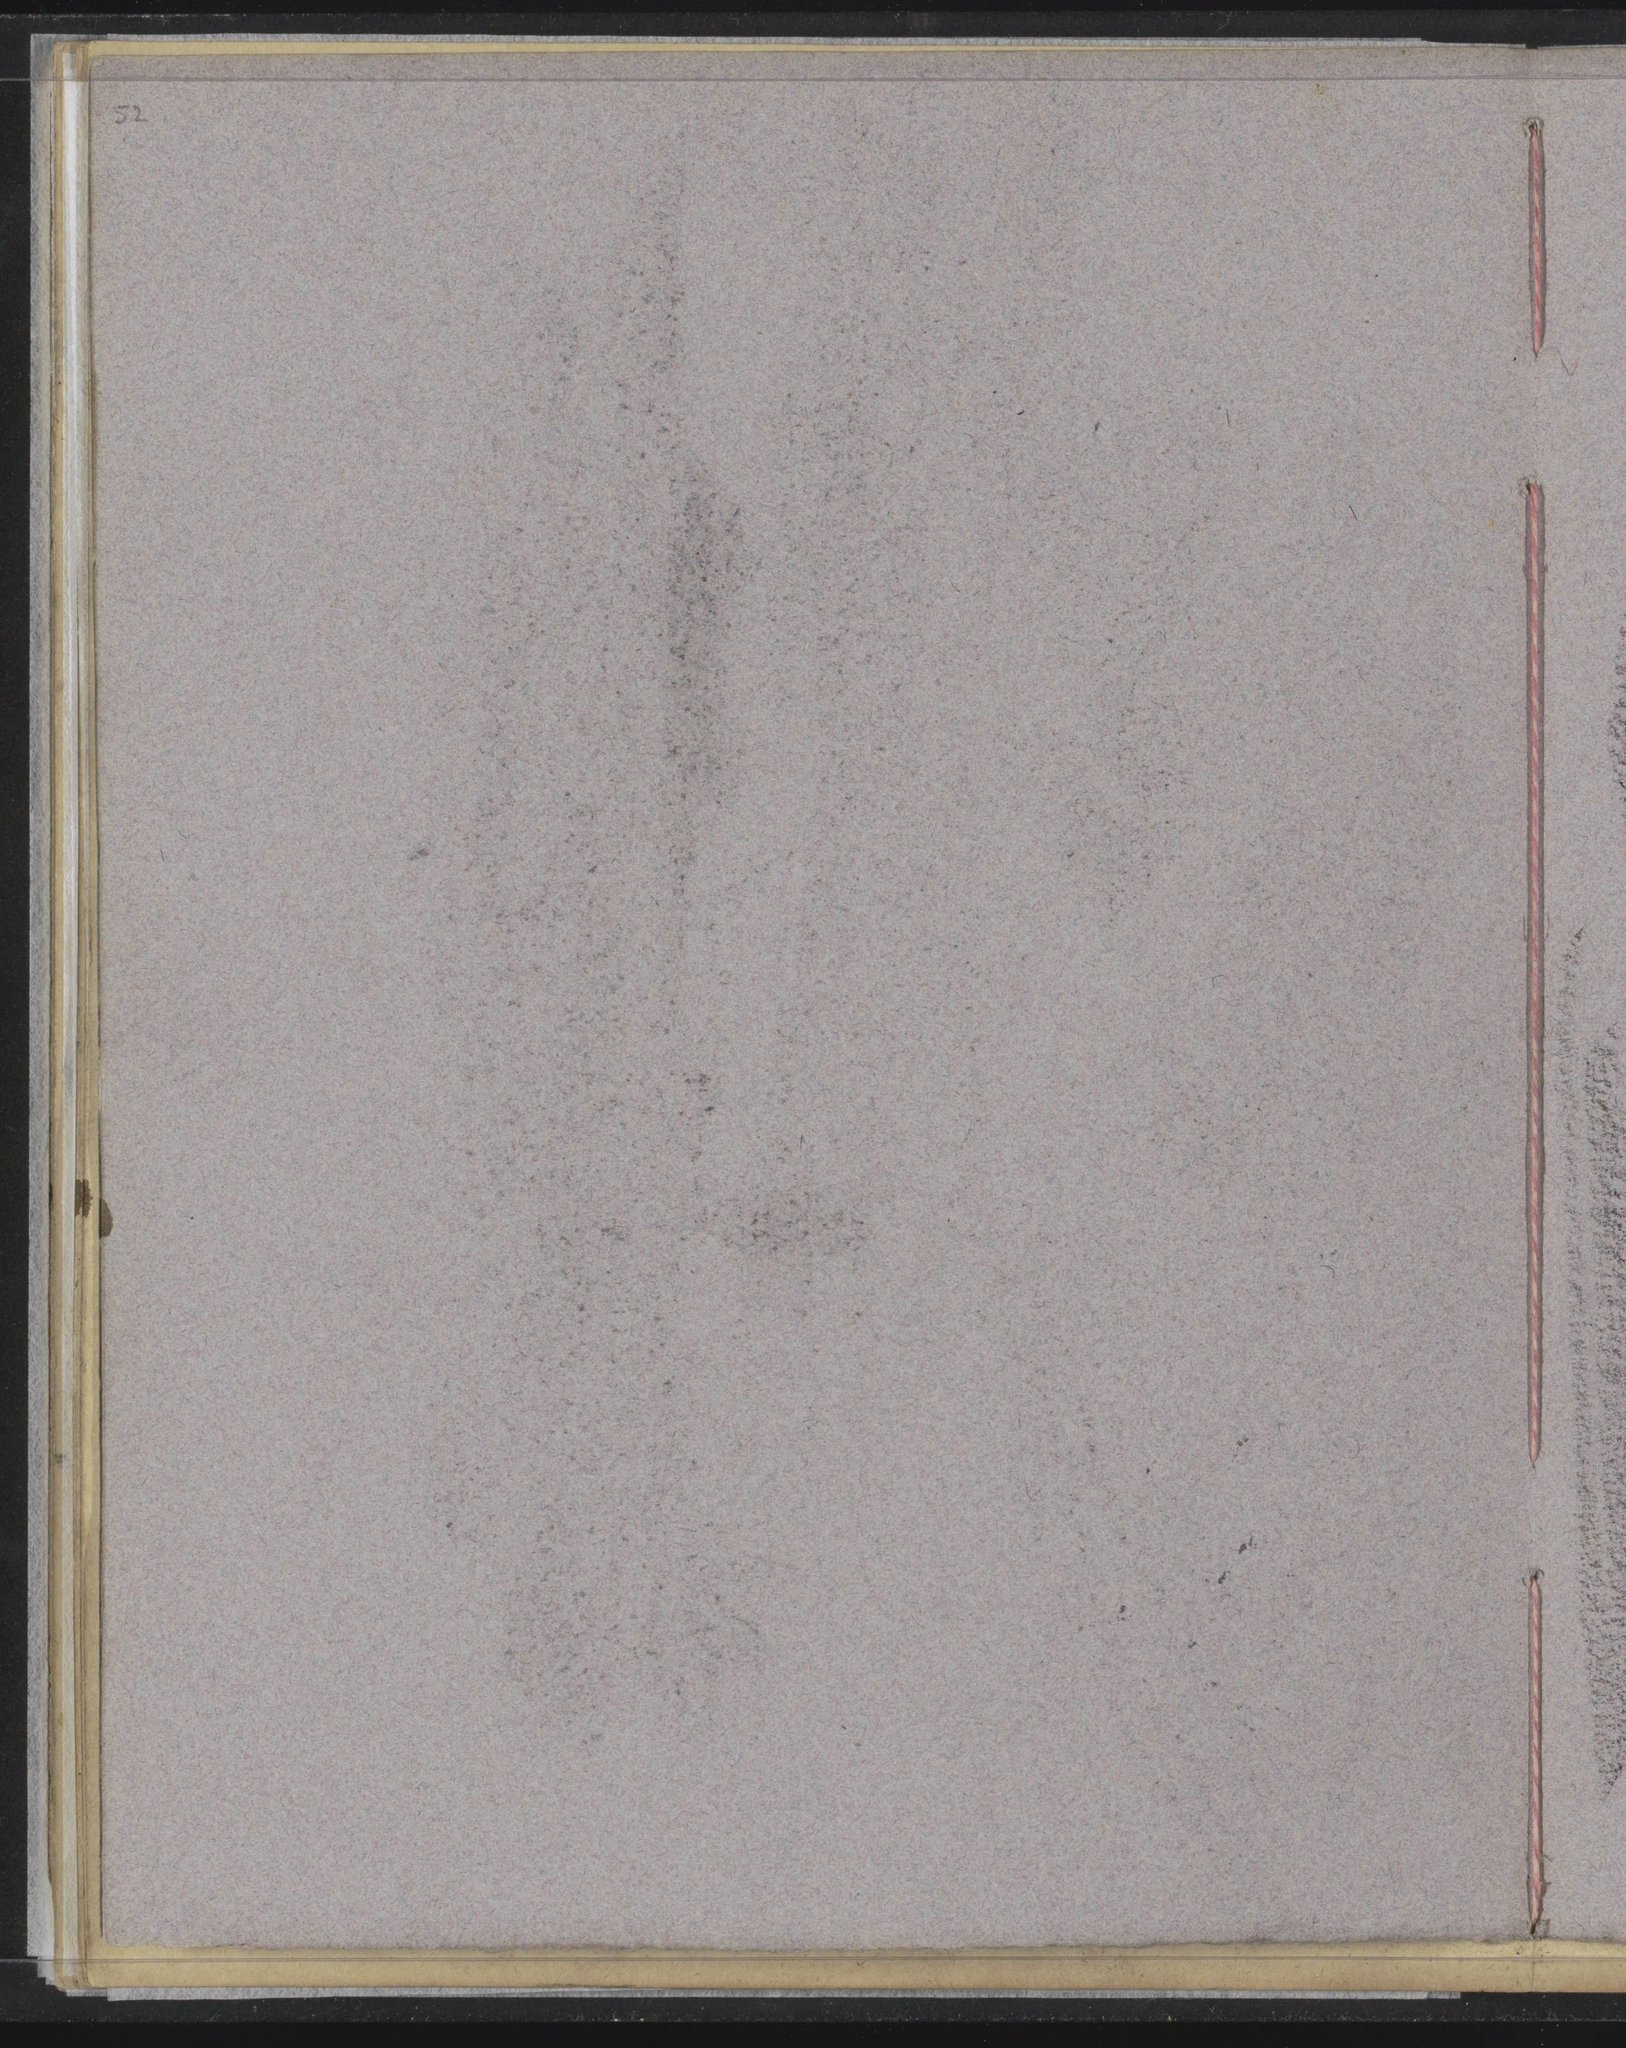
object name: sketchbook leaf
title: Abklatsch van de krijttekening op pagina 53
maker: willem witsen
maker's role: draughtsman, painter, print maker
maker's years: 1860-1923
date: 1887-1888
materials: paper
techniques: printmaking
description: Pagina 52 uit een schetsboek met 43 bladen.